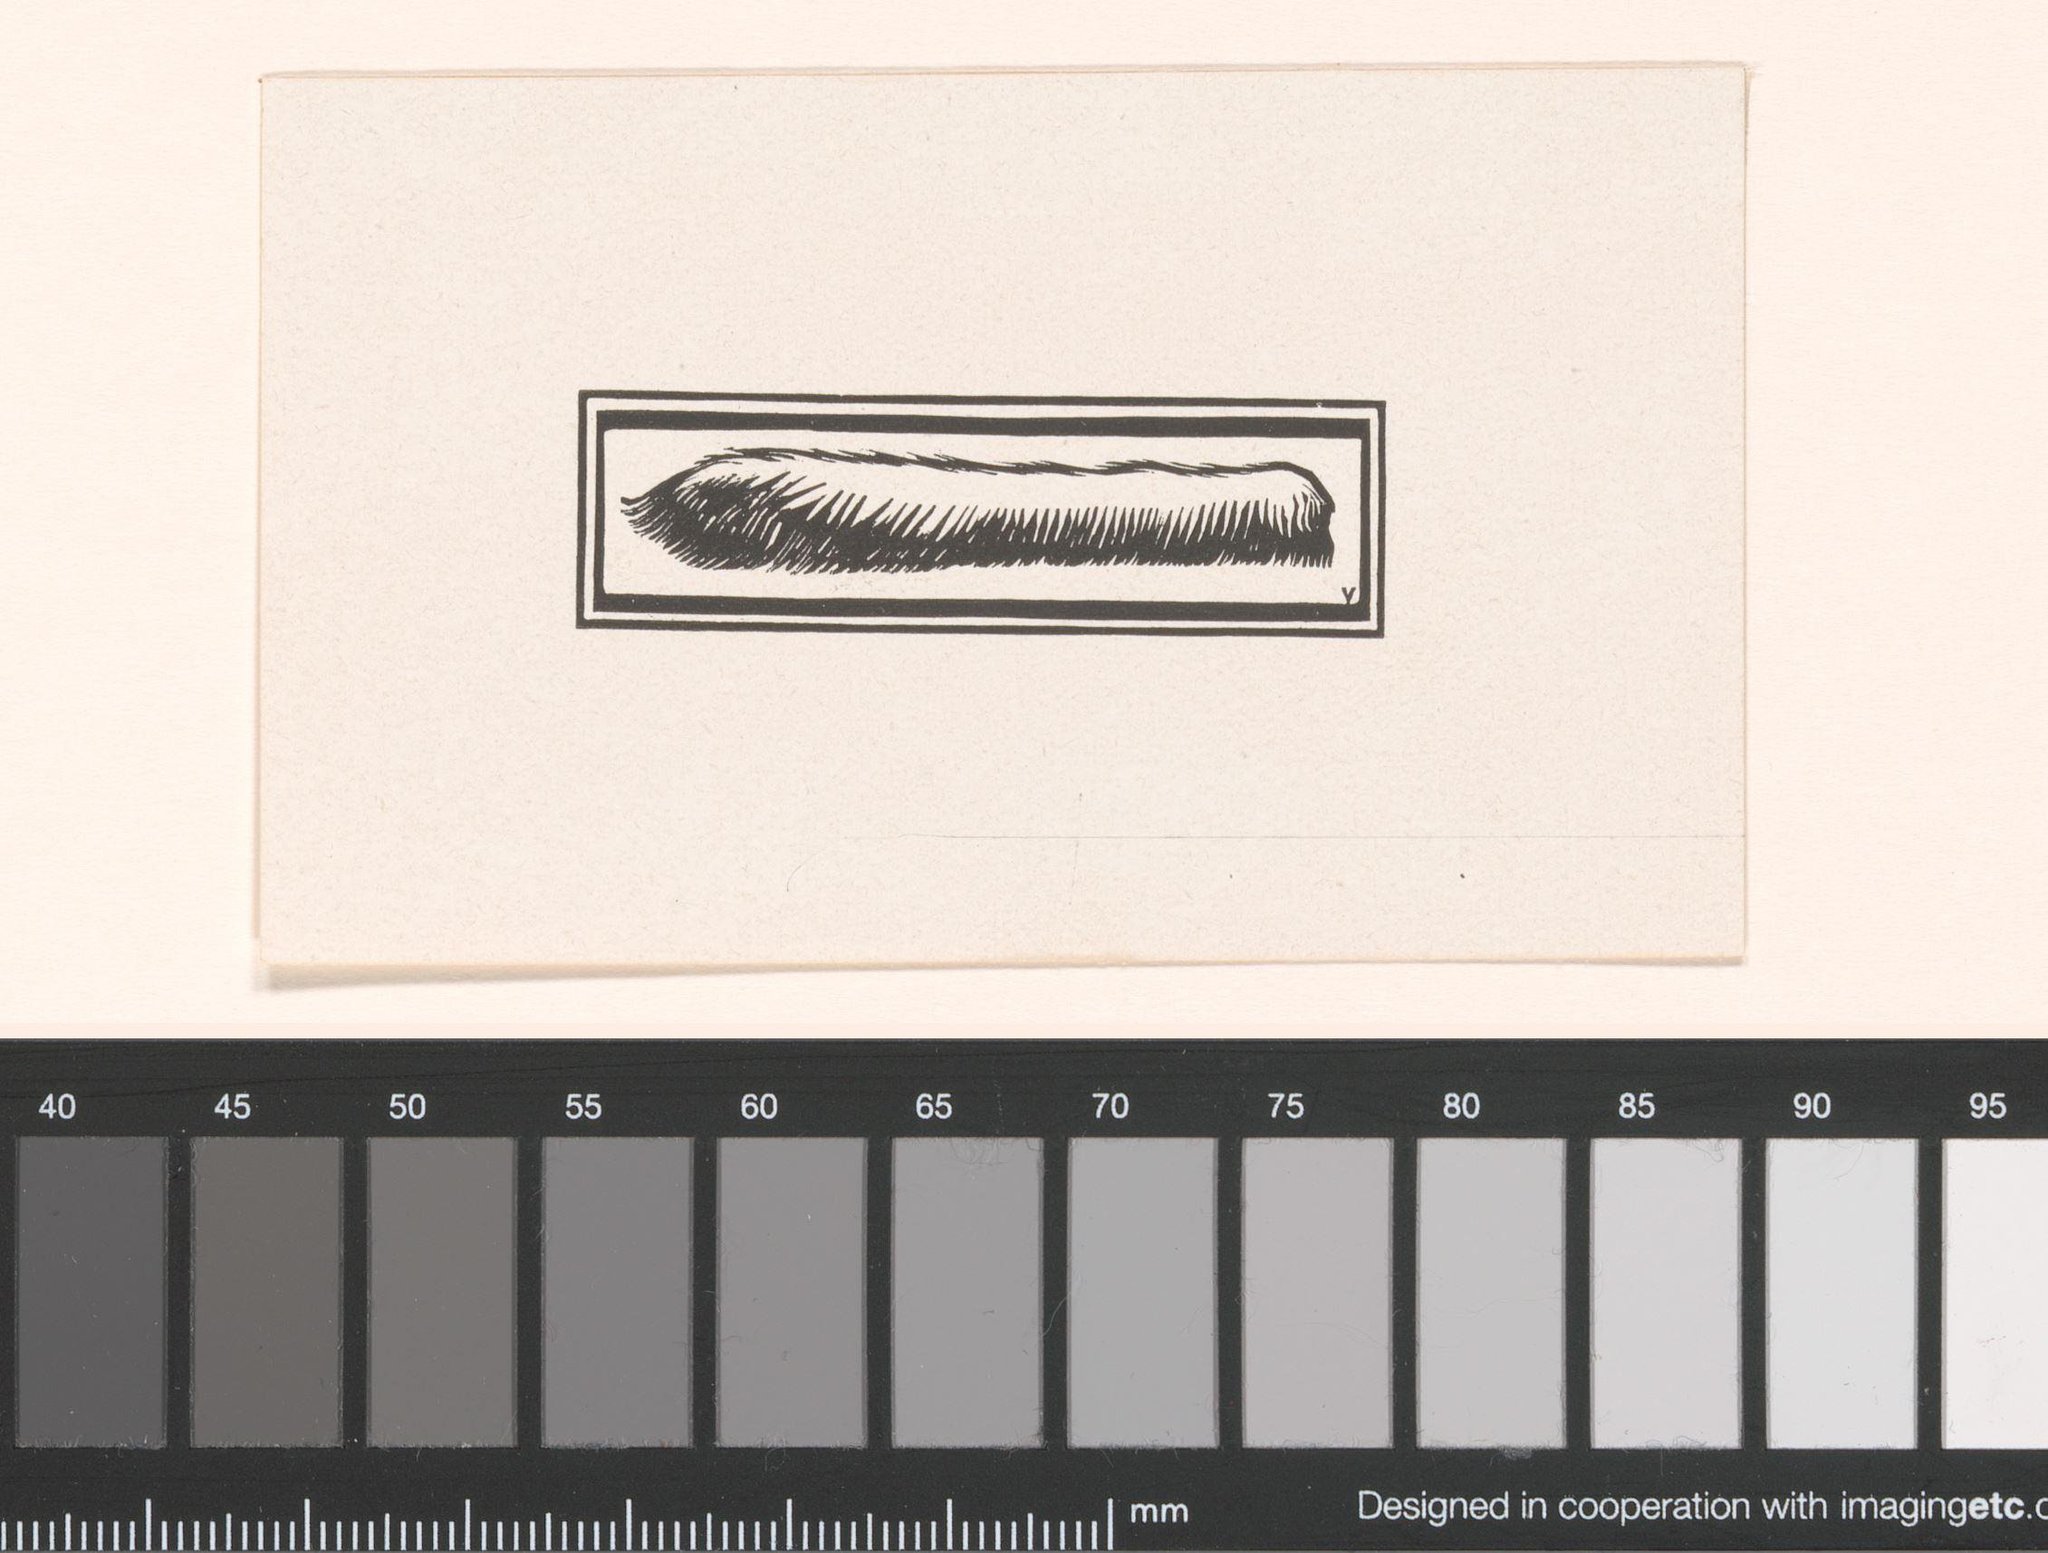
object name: vignette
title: Vignet met harig object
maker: elias voet jr.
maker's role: jeweler, print maker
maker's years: 1868-1940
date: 1878-1940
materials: paper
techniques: woodcut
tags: vignette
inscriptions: collector's mark: Lugt 2228